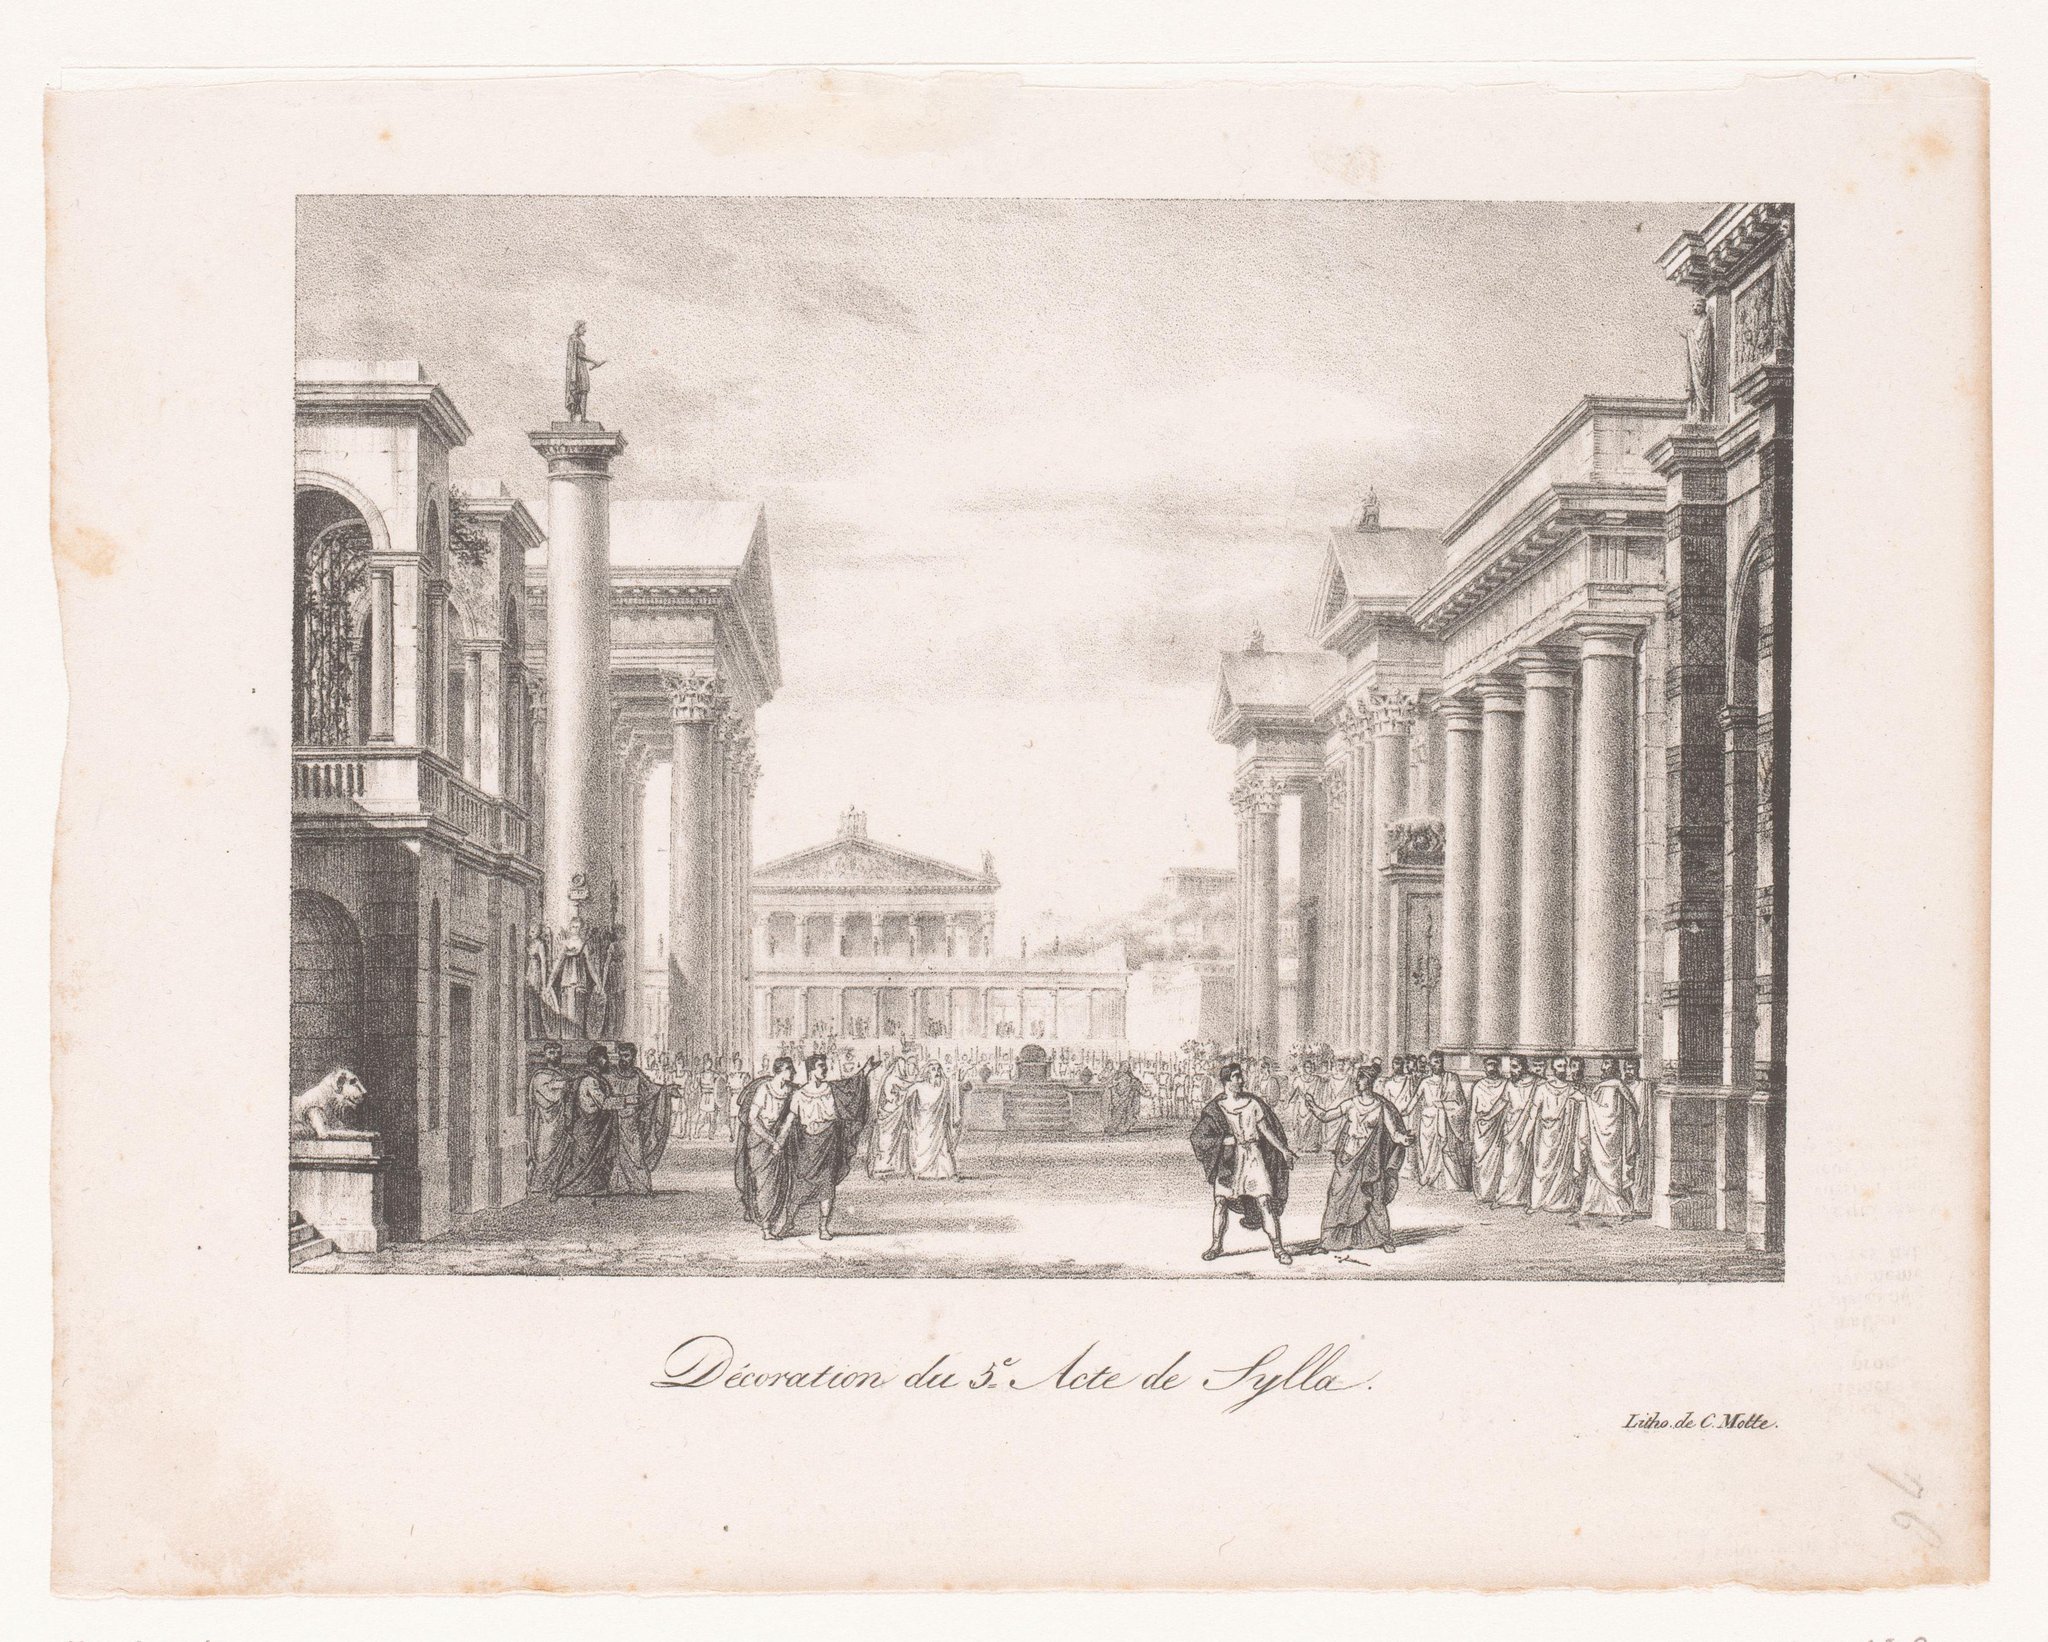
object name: print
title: Theaterdecor voor de vijfde acte van een toneelstuk over Sulla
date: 1817-1837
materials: paper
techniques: lithograph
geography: paris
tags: theatre, theatrical performance, classical mythology and ancient history, stage design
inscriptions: collector's mark: Lugt 2228